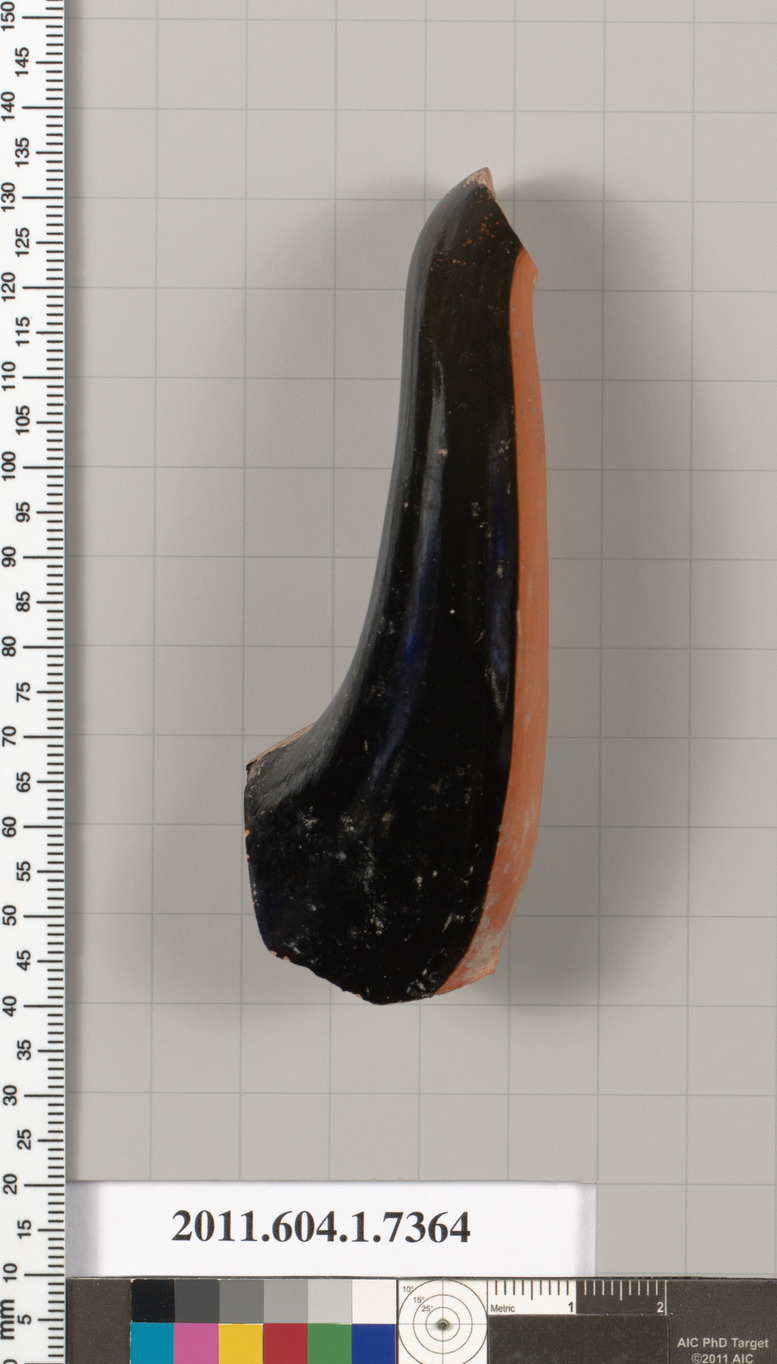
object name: kylix fragment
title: Terracotta fragment of a kylix (drinking cup)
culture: greek, attic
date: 500-480 BCE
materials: terracotta